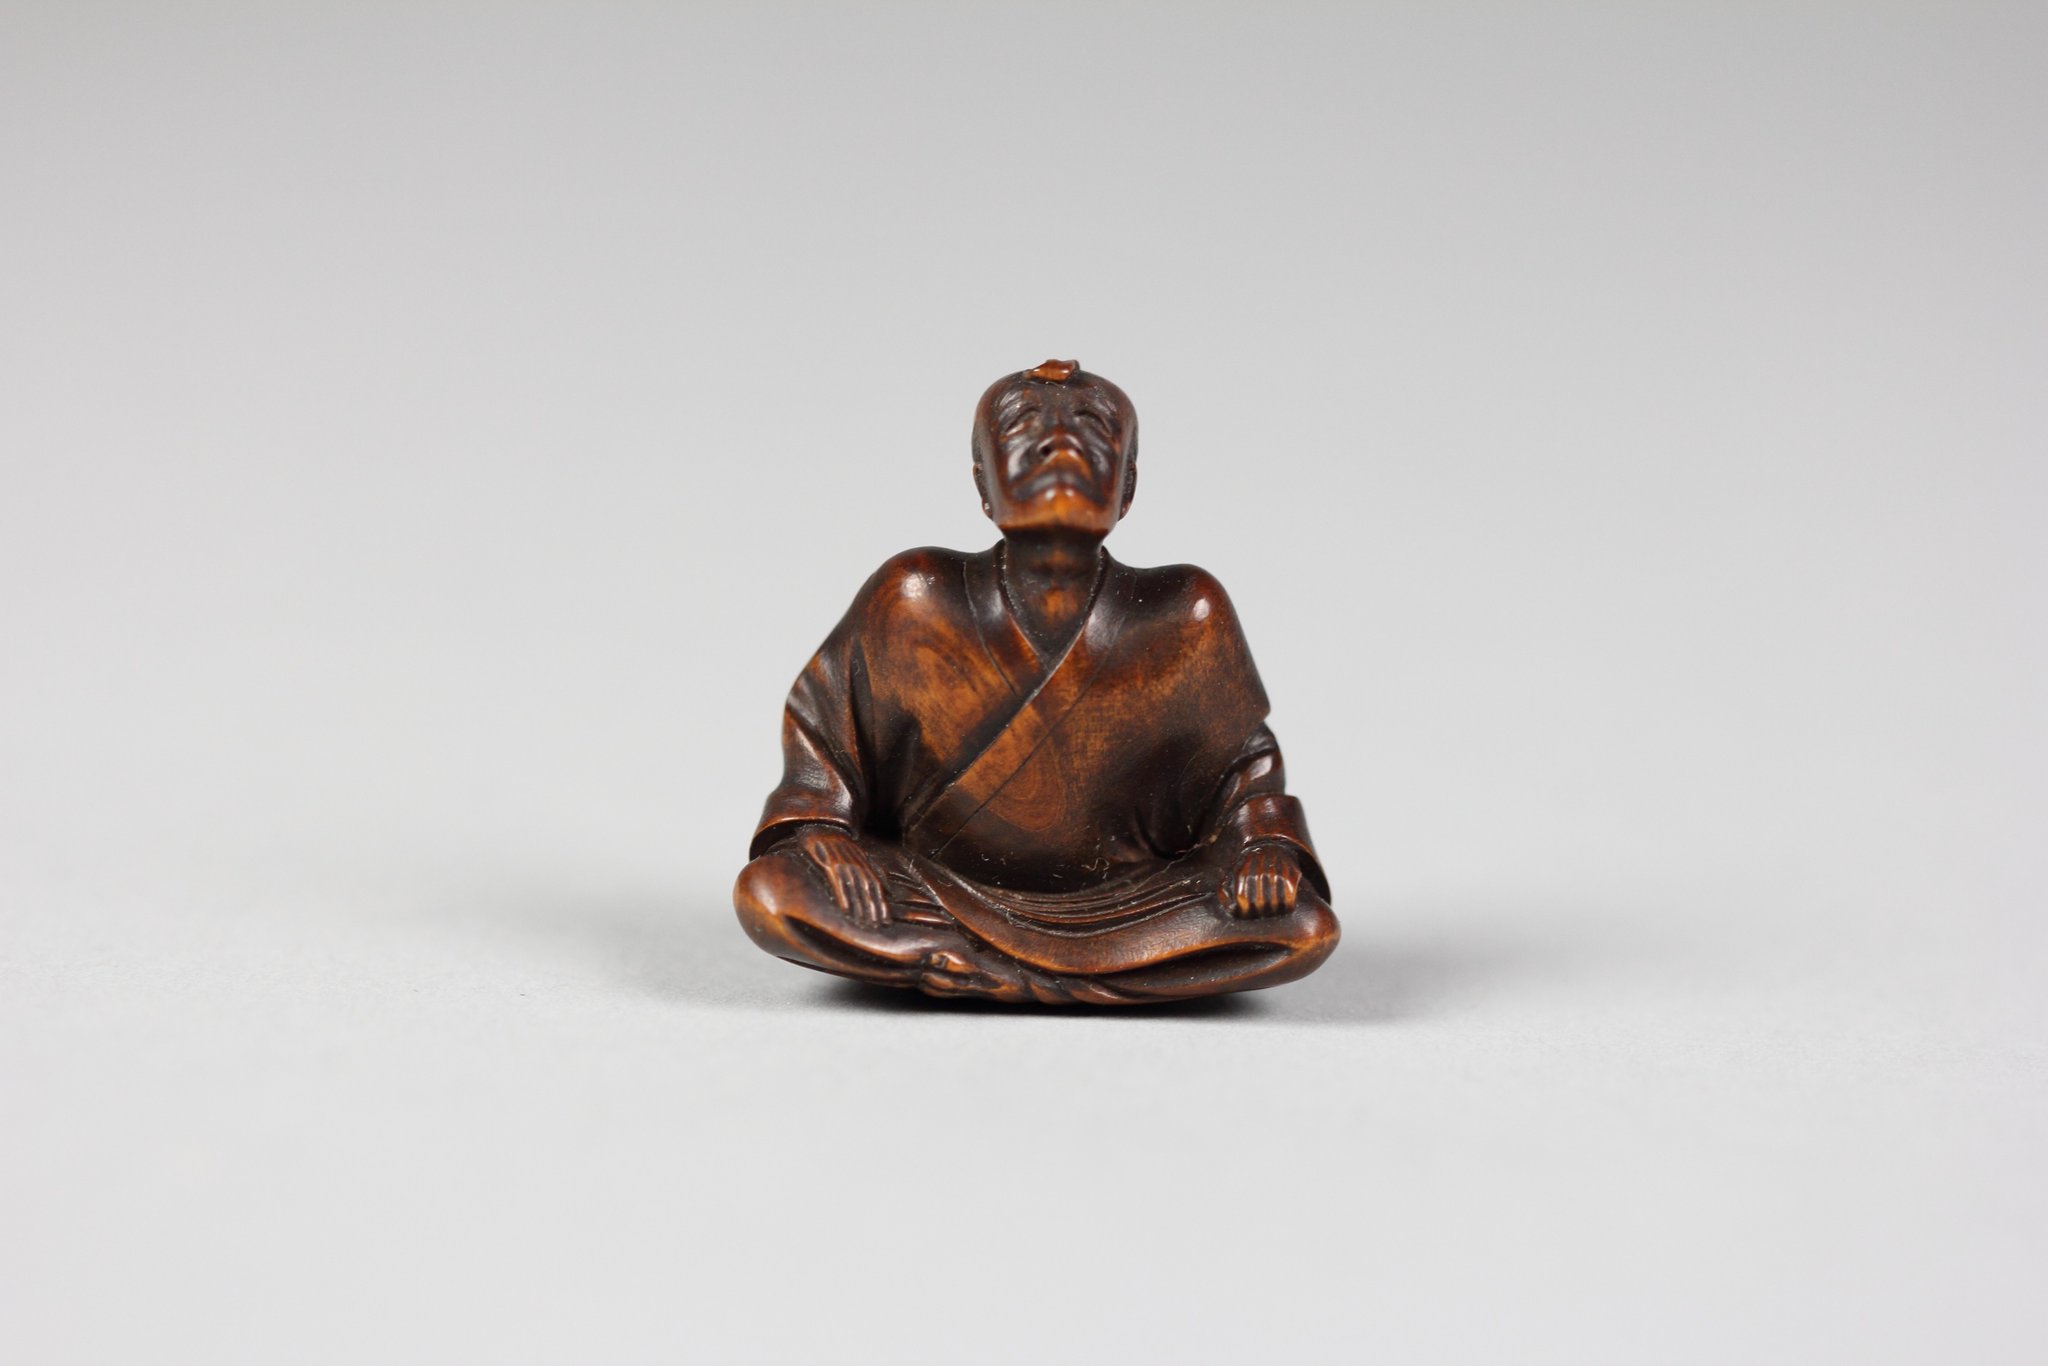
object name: netsuke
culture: japanese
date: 1801-1900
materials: wood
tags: men